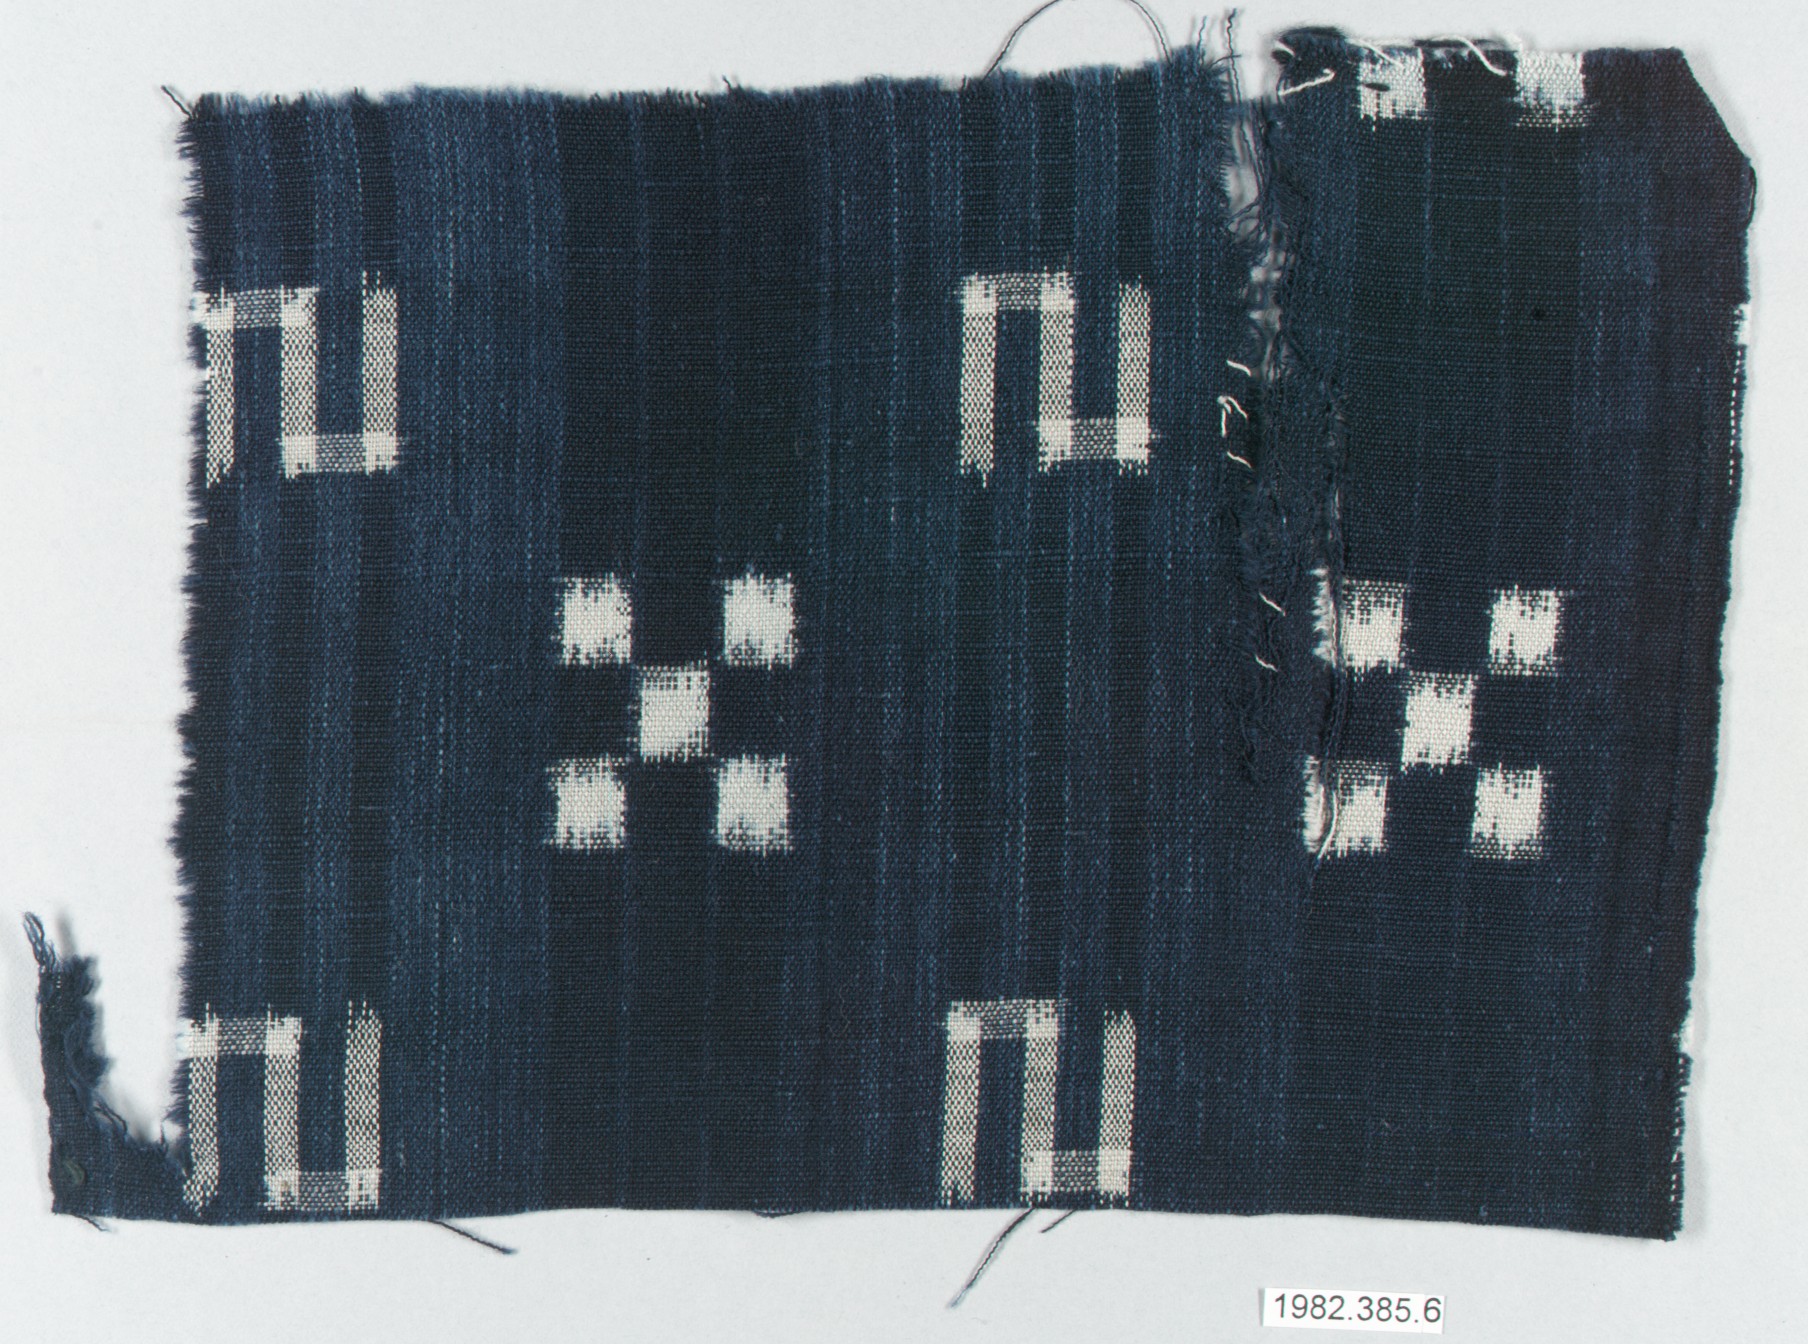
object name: piece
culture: japanese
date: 1868-1926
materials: cotton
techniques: dyeing